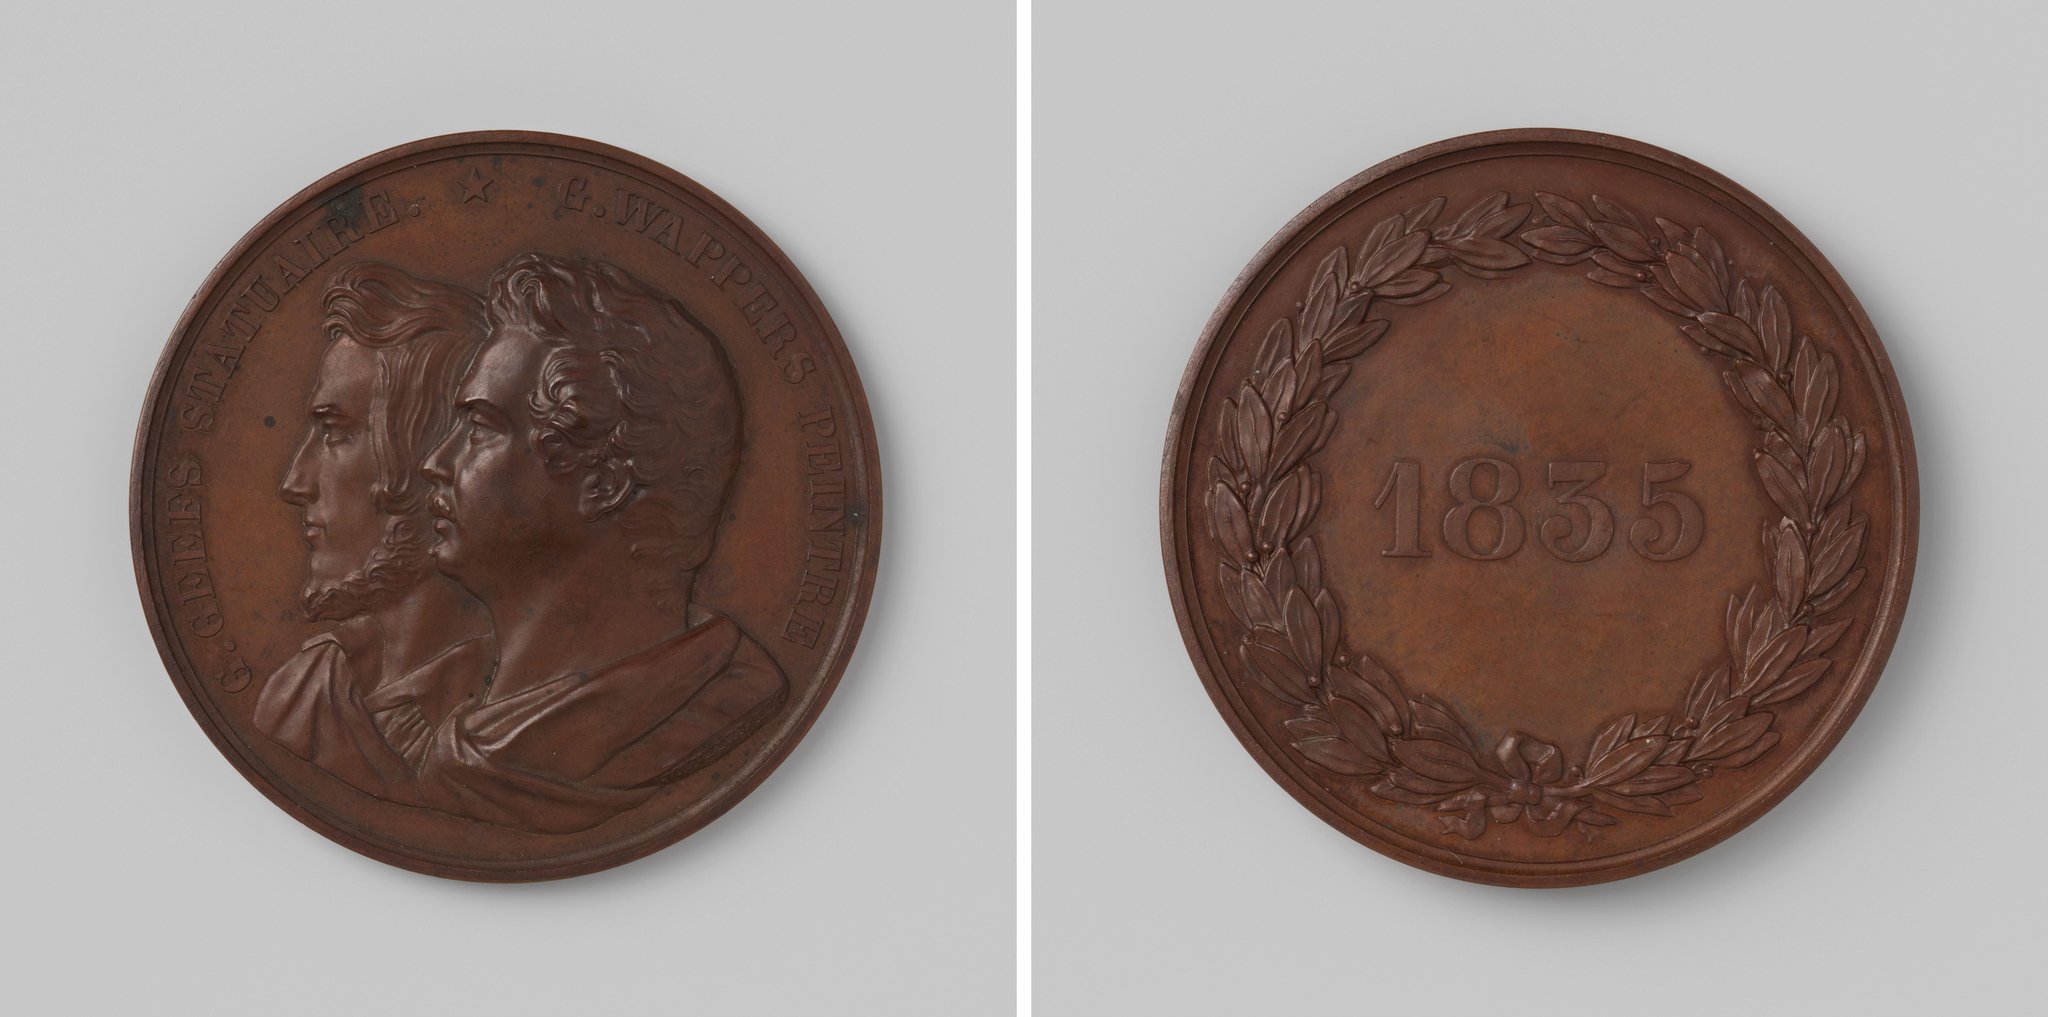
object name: history medal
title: Gustave Wappers, schilder te Antwerpen en Willem Geefs, beeldhouwer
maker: adolphe jouvenel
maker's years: 1798-1867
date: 1835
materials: bronze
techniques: striking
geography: belgium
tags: sculptor, willem geefs, antwerp, paris, draughtsman, gustave wappers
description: Bronzen penning. Voorzijde: borststukken van twee mannen binnen omschrift. Keerzijde: jaartal binnenlauwerkrans